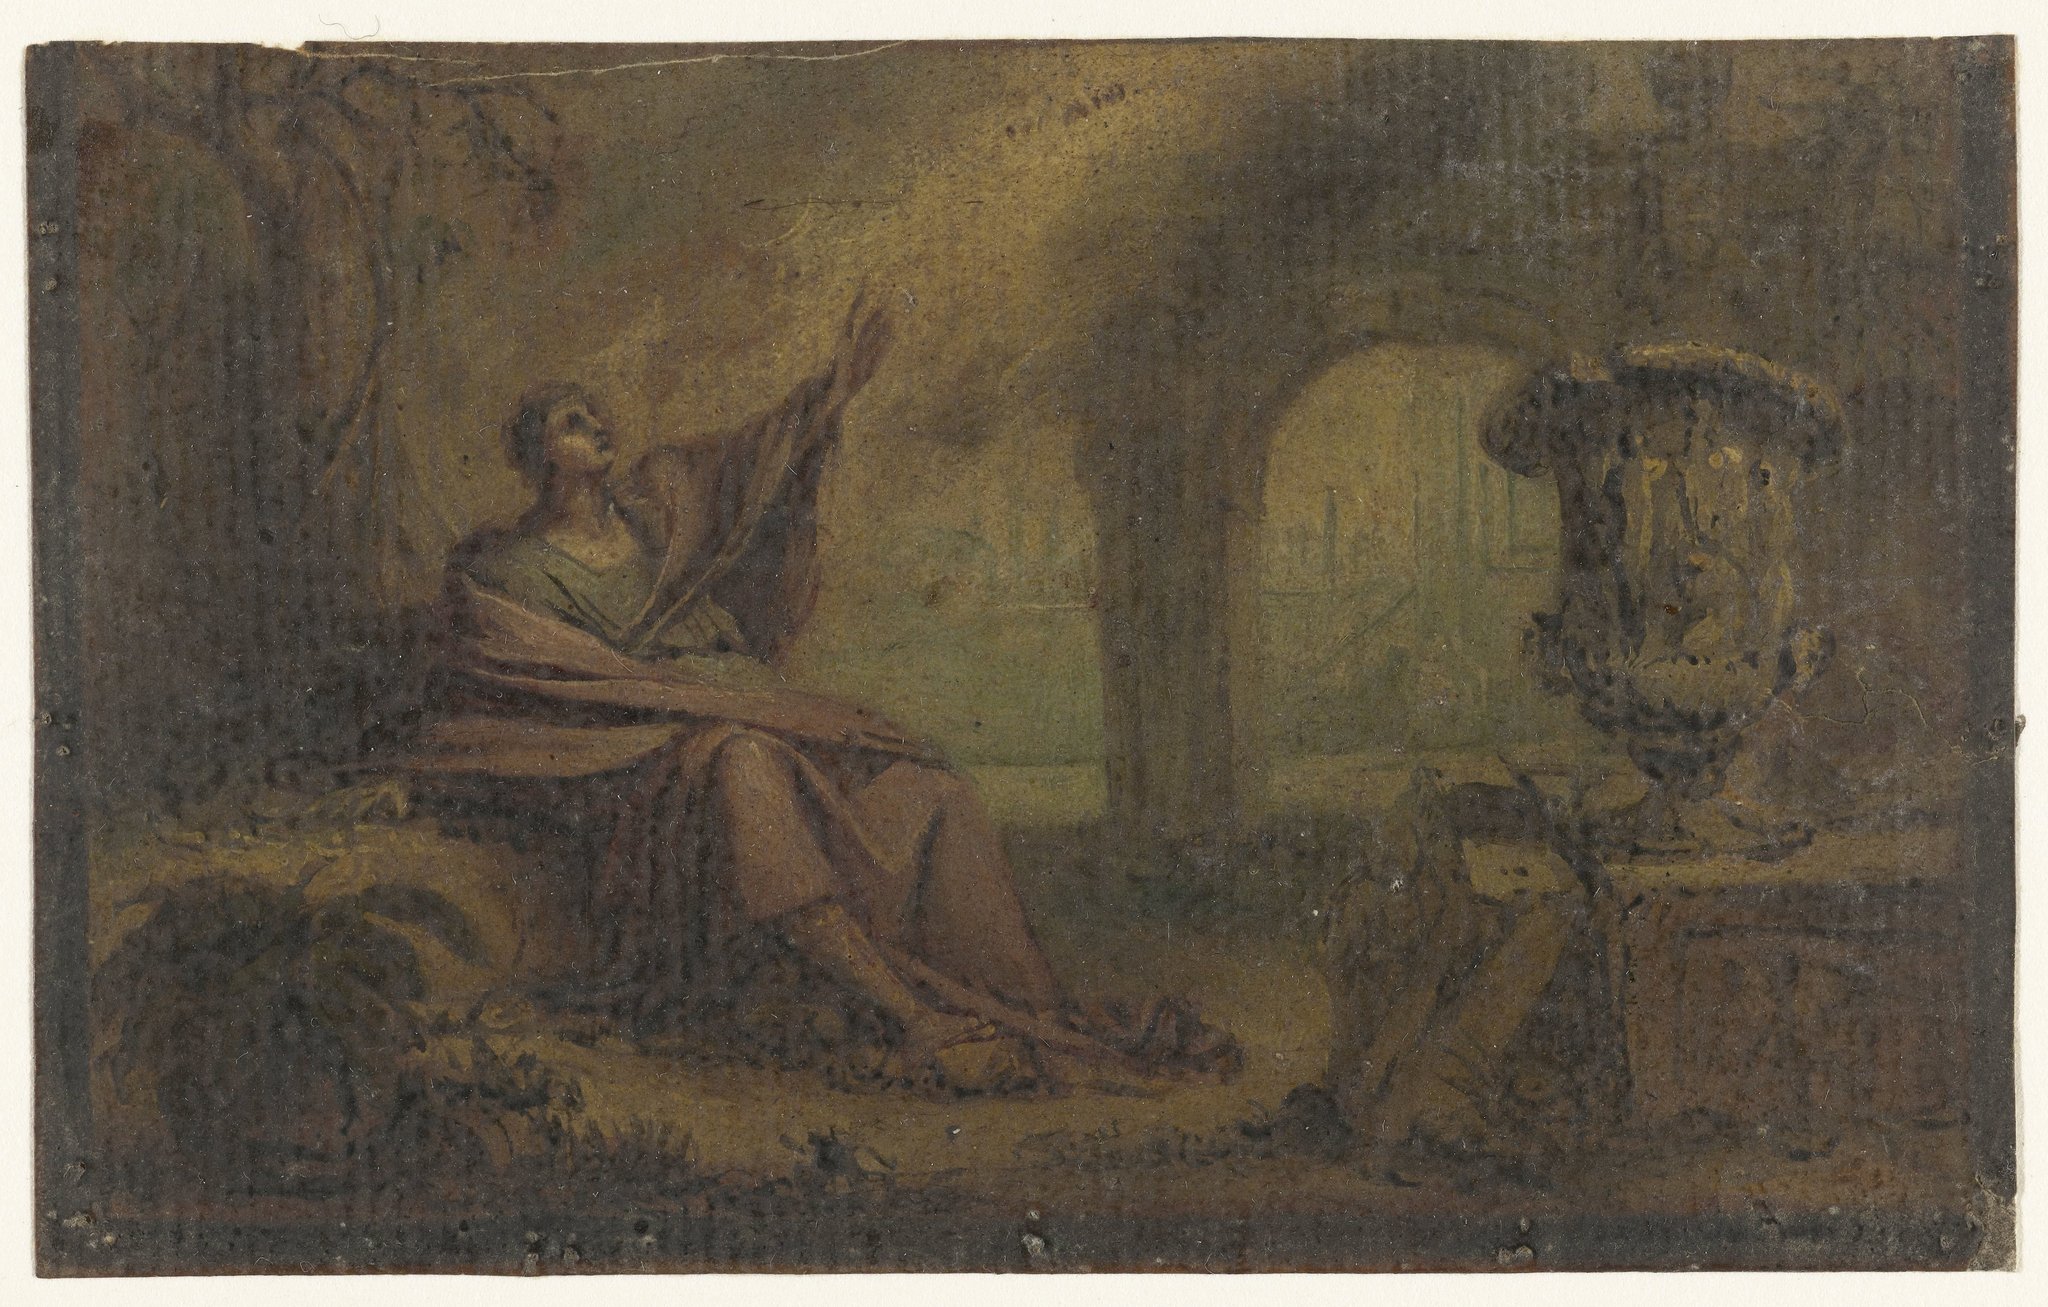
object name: drawing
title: Johannes op Patmos (?)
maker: Anonymous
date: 1700-1800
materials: oil, paper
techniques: brush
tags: john (writing) on the island of patmos, possibly the eagle beside him